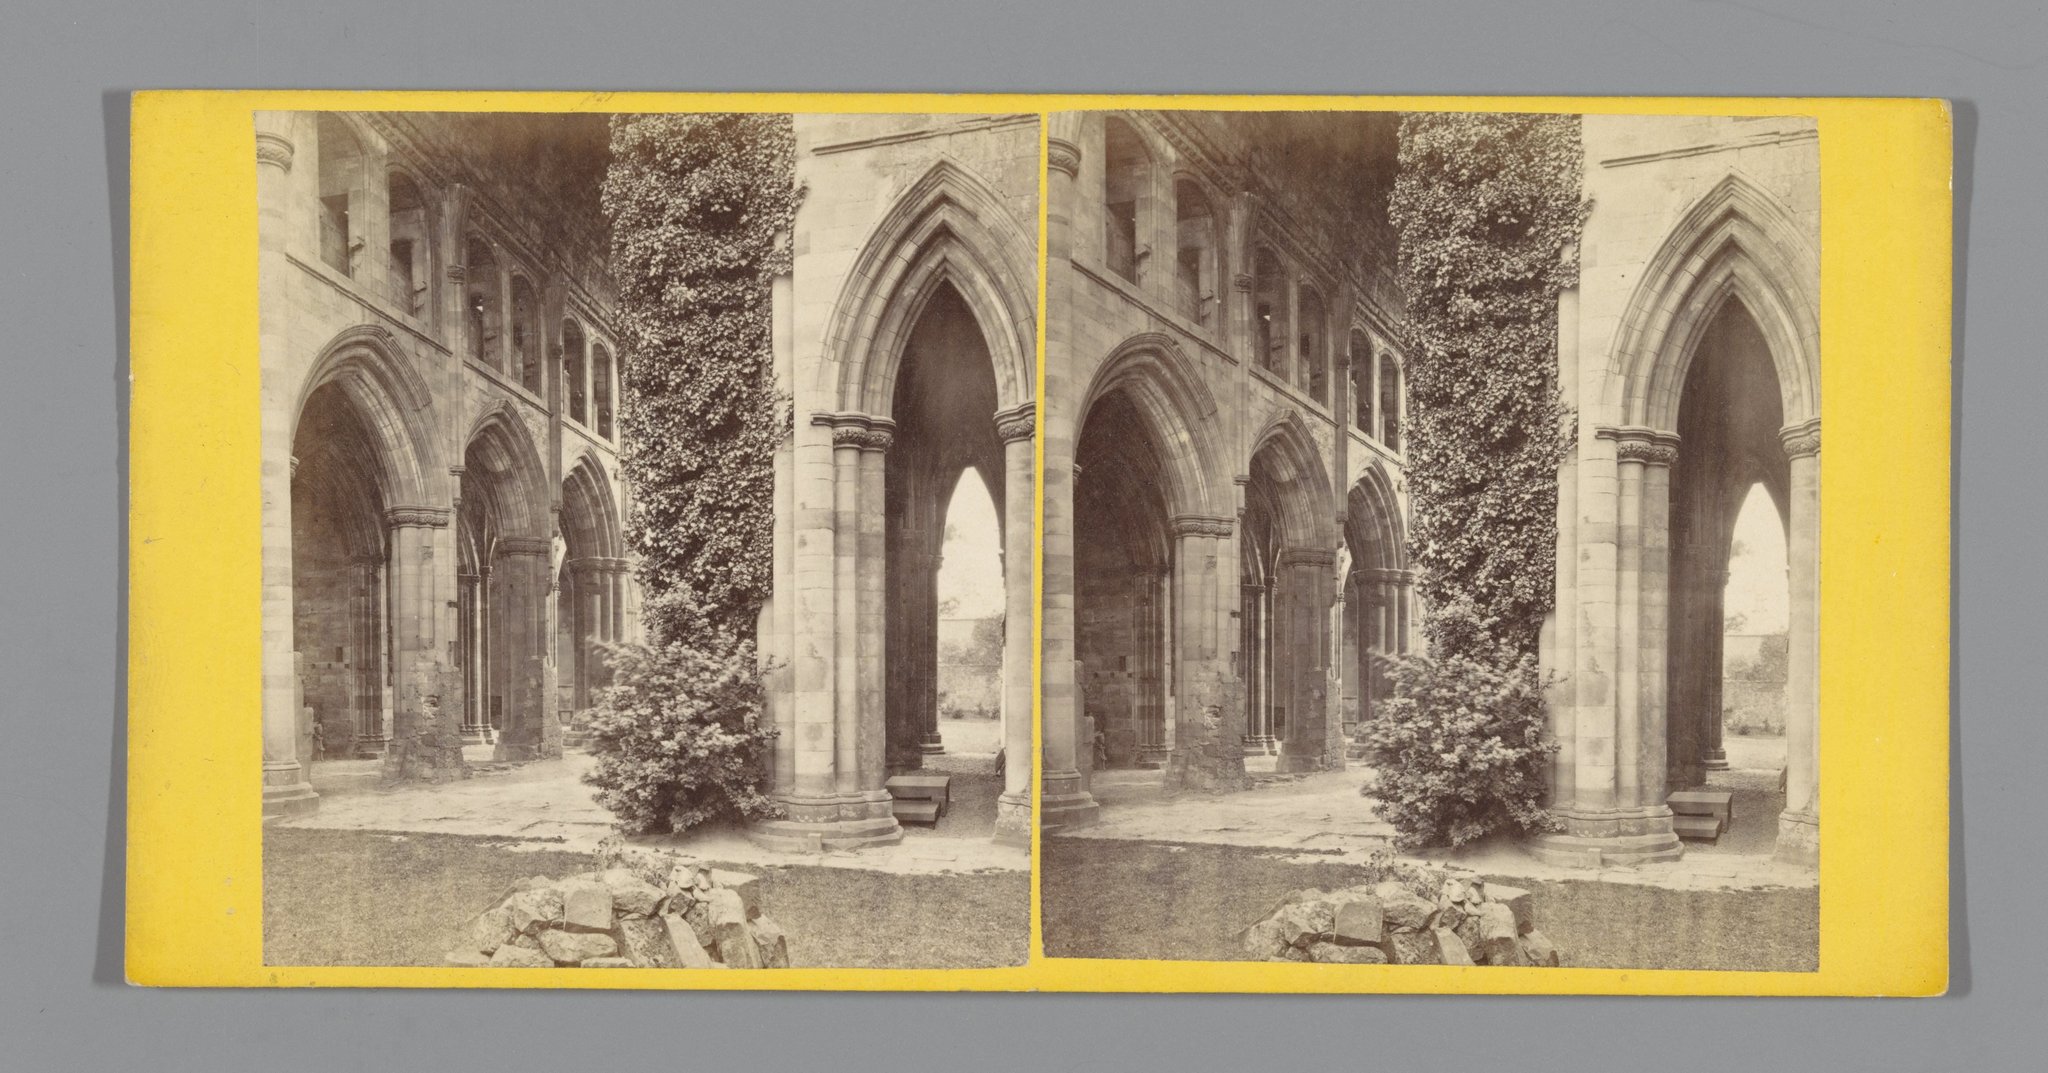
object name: stereograph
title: Schip in de ruïne van Melrose Abbey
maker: george washington wilson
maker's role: publisher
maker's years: 1823-1893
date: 1850-1880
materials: cardboard, photographic support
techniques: albumen print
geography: melrose abbey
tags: ruin of church, monastery, etc.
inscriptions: number: ‘No. 100.’, name: ‘Registered G. W. Wilson, Photographer, Aberdeen’